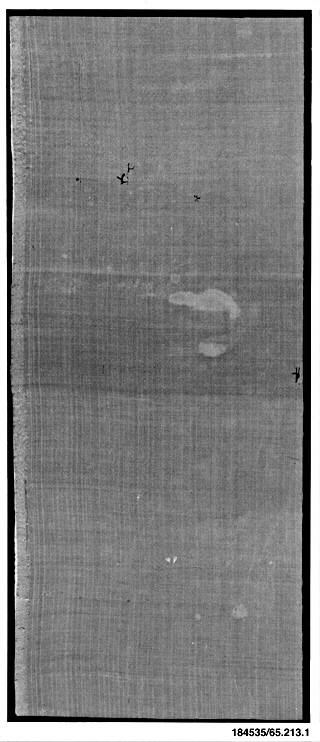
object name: shosoin fragment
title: Shōsōin fragment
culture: japanese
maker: kochi-no-tanushi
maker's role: artist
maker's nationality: japanese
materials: silk